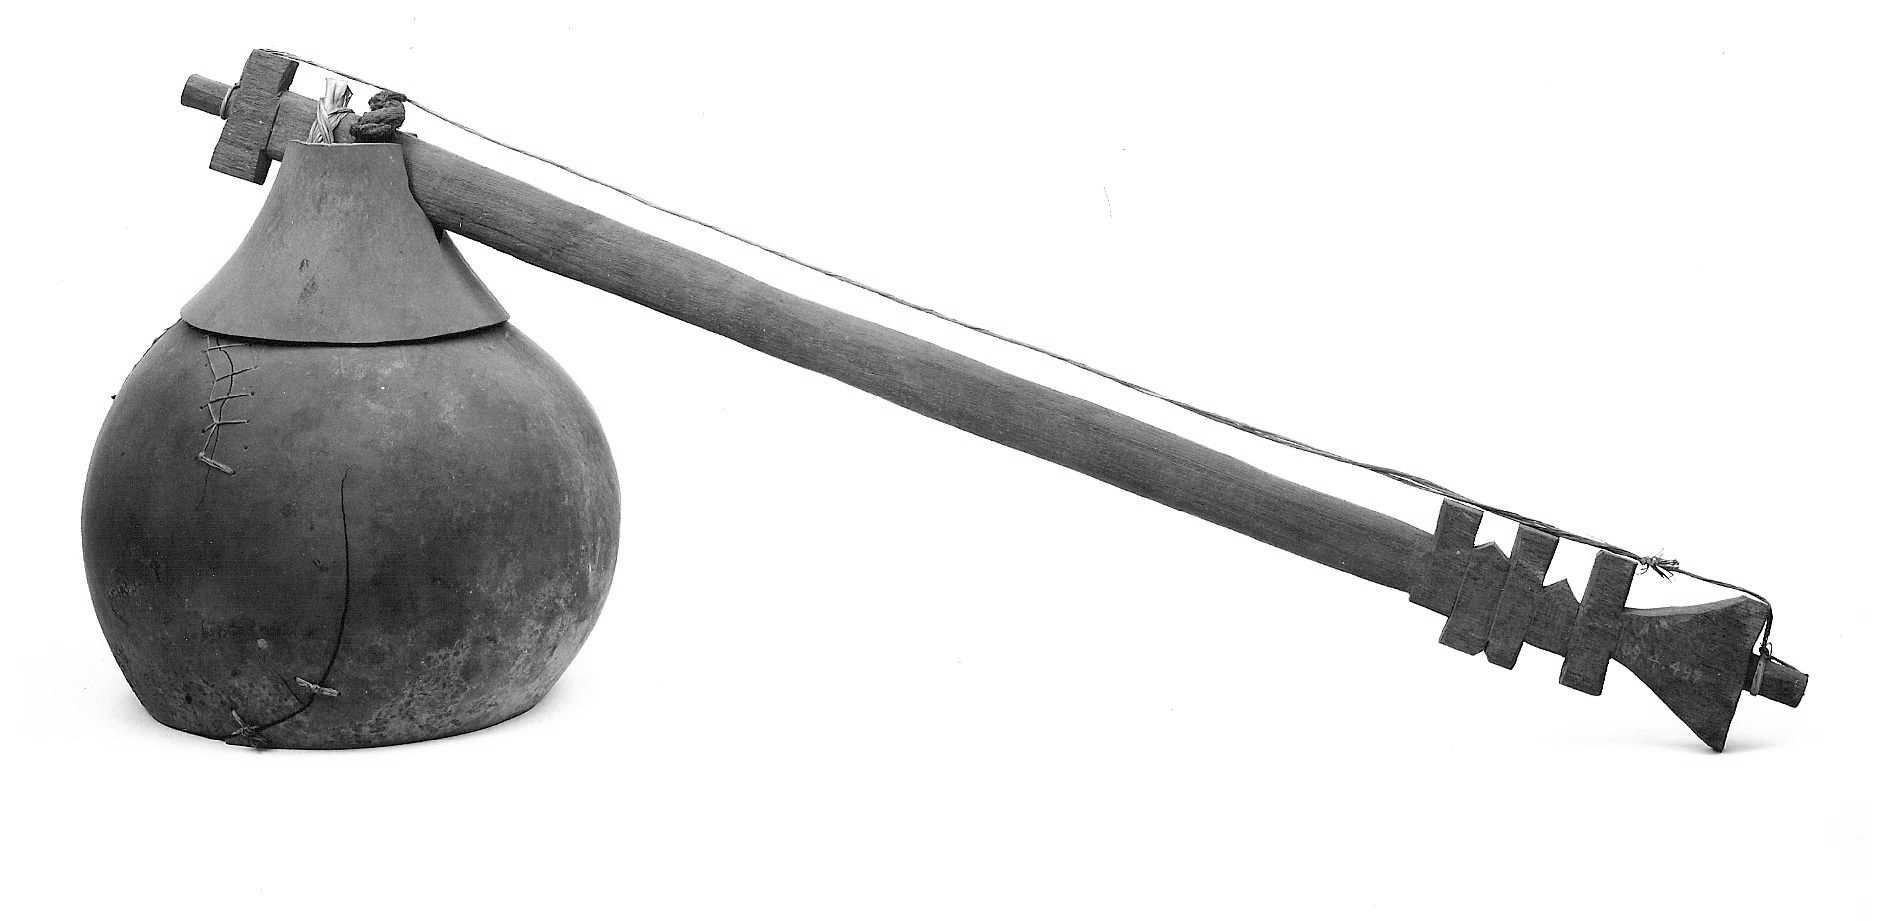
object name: herrauou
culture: malagasy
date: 1867-1900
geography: madagascar